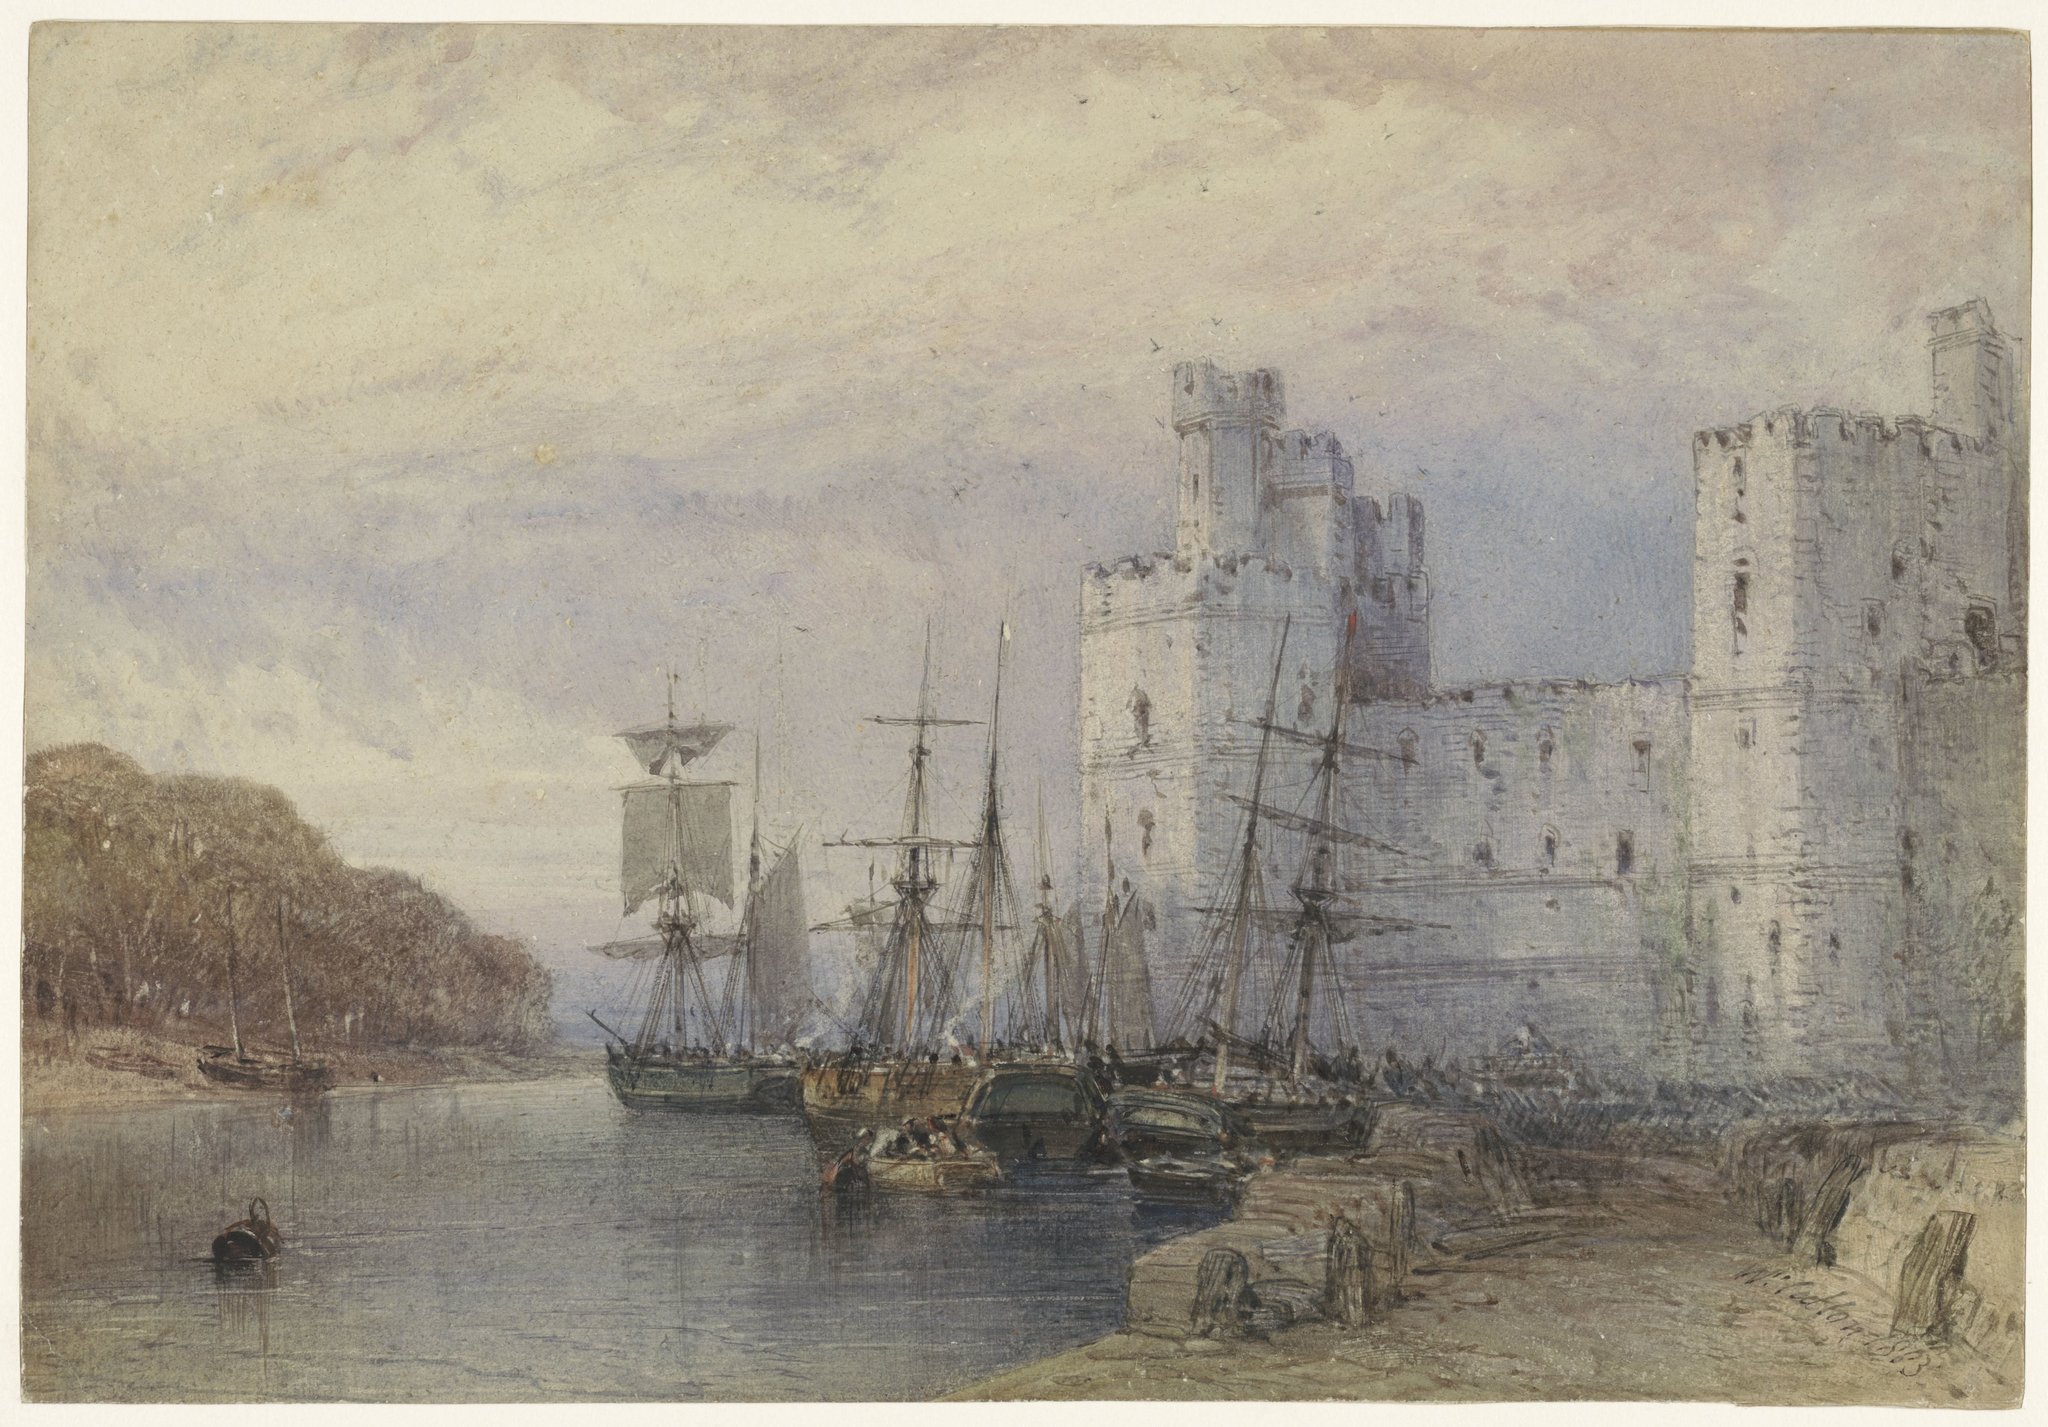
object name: drawing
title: Landschap met schepen voor Caernarvon Castle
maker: william callow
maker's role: draughtsman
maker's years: 1812-1908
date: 1883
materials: paper, paint, watercolor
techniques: brush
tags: castle, river (+ landscape with figures, staffage), landscape with tower or castle (+ city(-scape) with figures, staffage)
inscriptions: inscription: ‘No.46, Carnarvon Castle.’